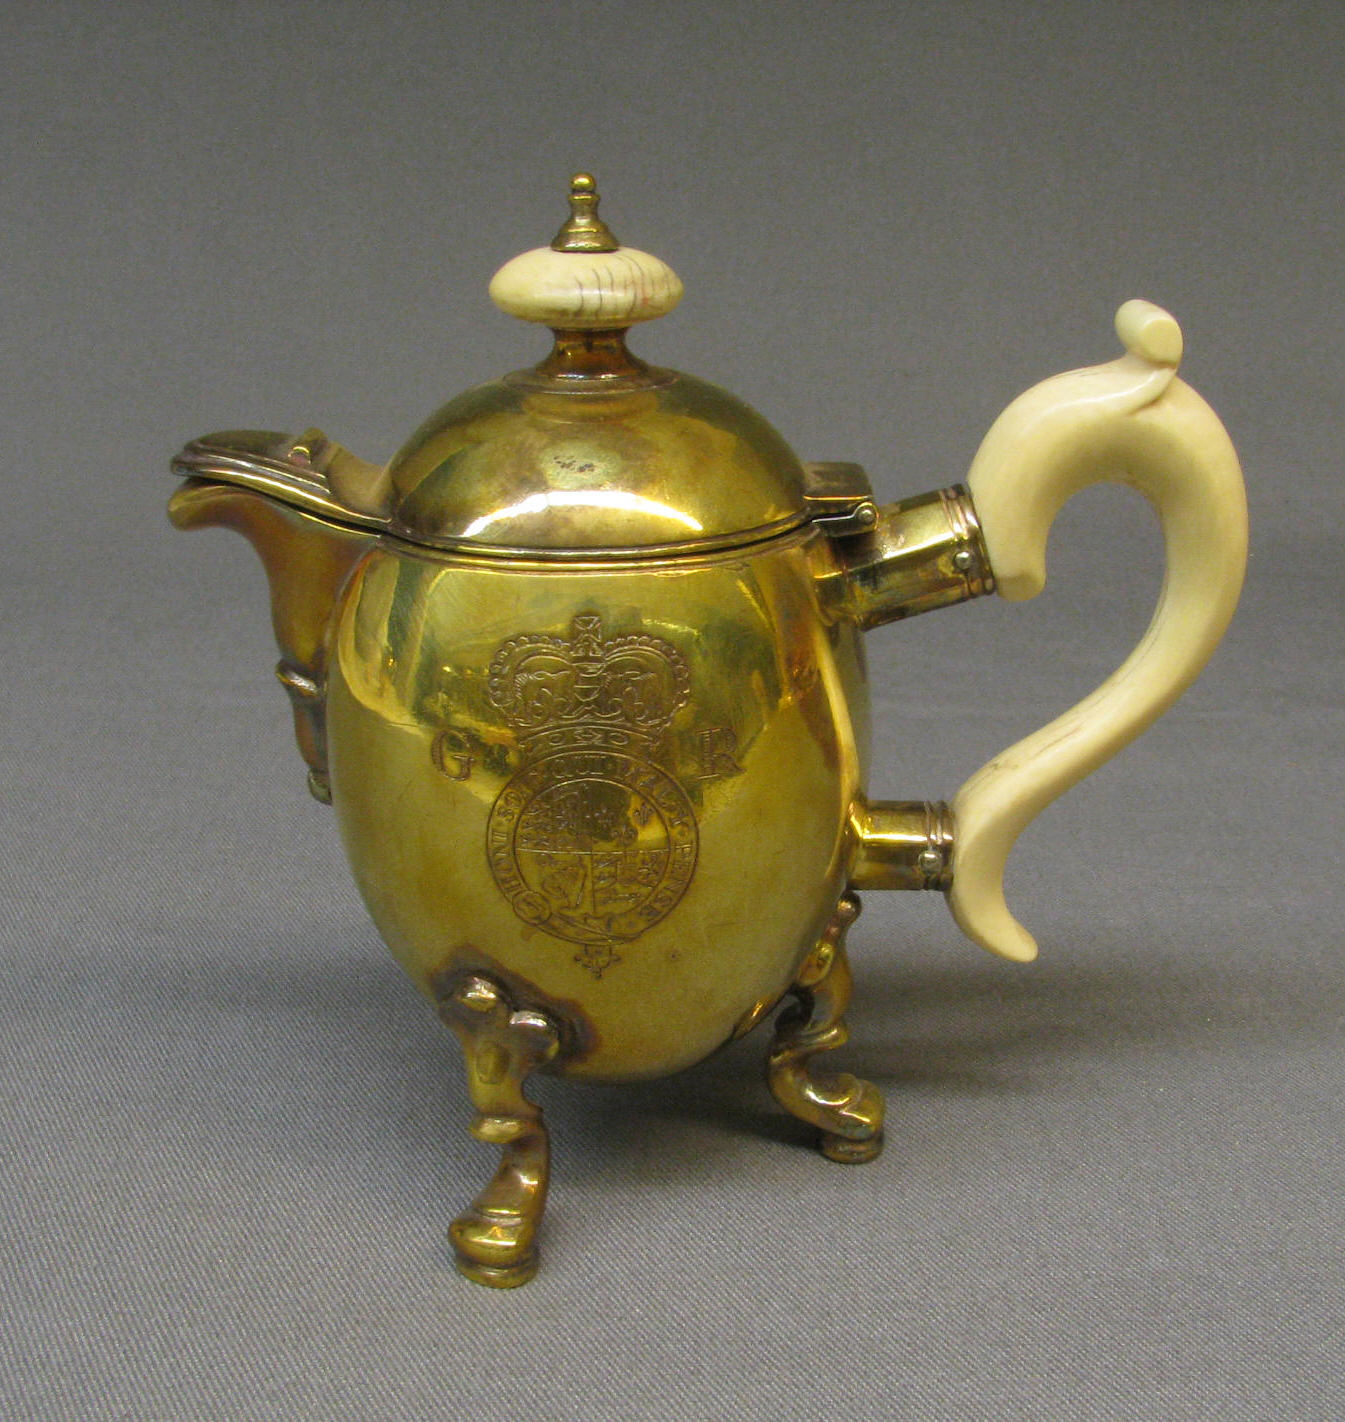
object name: jug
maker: simon pantin i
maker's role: maker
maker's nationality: british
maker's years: 1672-1728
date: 1727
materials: ivory, silver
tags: coat of arms